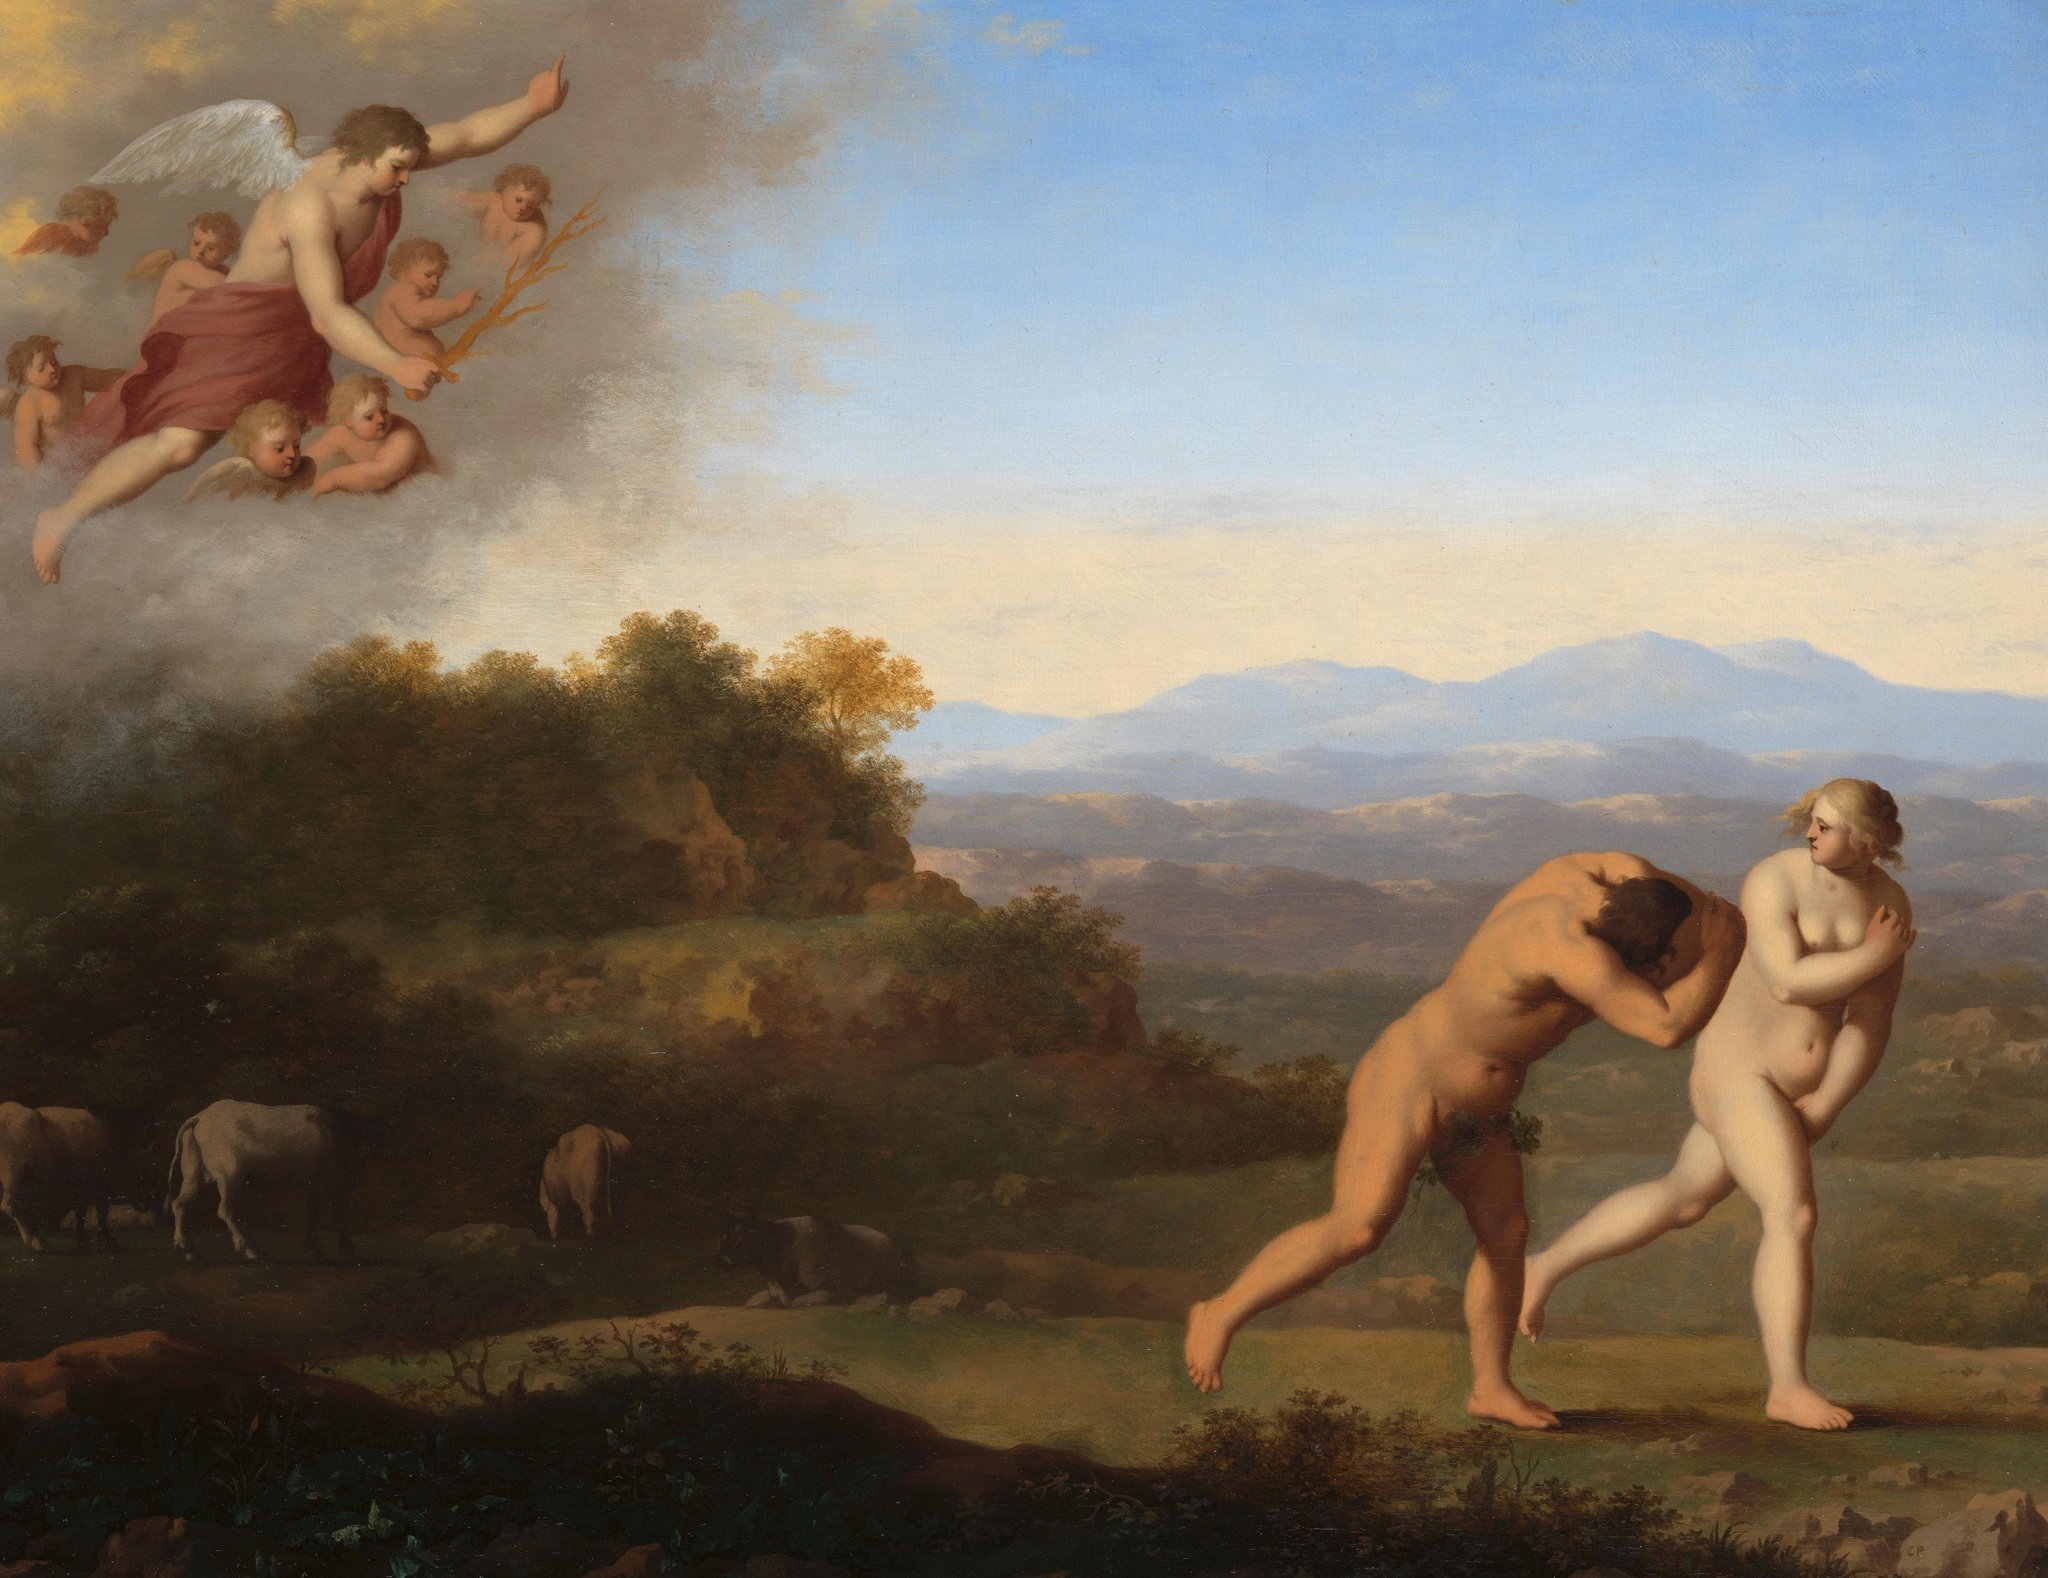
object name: painting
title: The Expulsion from Paradise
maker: cornelis van poelenburch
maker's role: draughtsman, painter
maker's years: 1594-1667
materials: oil, paint, panel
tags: expulsion of adam and eve from paradise (genesis 3:22-24)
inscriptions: signature, lower right, with monogram: ‘C·P·’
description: Although God forbade Adam and Eve to eat the fruit of the ‘tree of the knowledge of good and evil’, they did so anyway. As punishment, they were driven out of Paradise by an angel with a flaming sword. They fled into the barren mountain landscape. Van Poelenburch, after returning to the Netherlands from Italy, produced this type of highly refined, painstakingly painted landscape throughout the rest of his career.